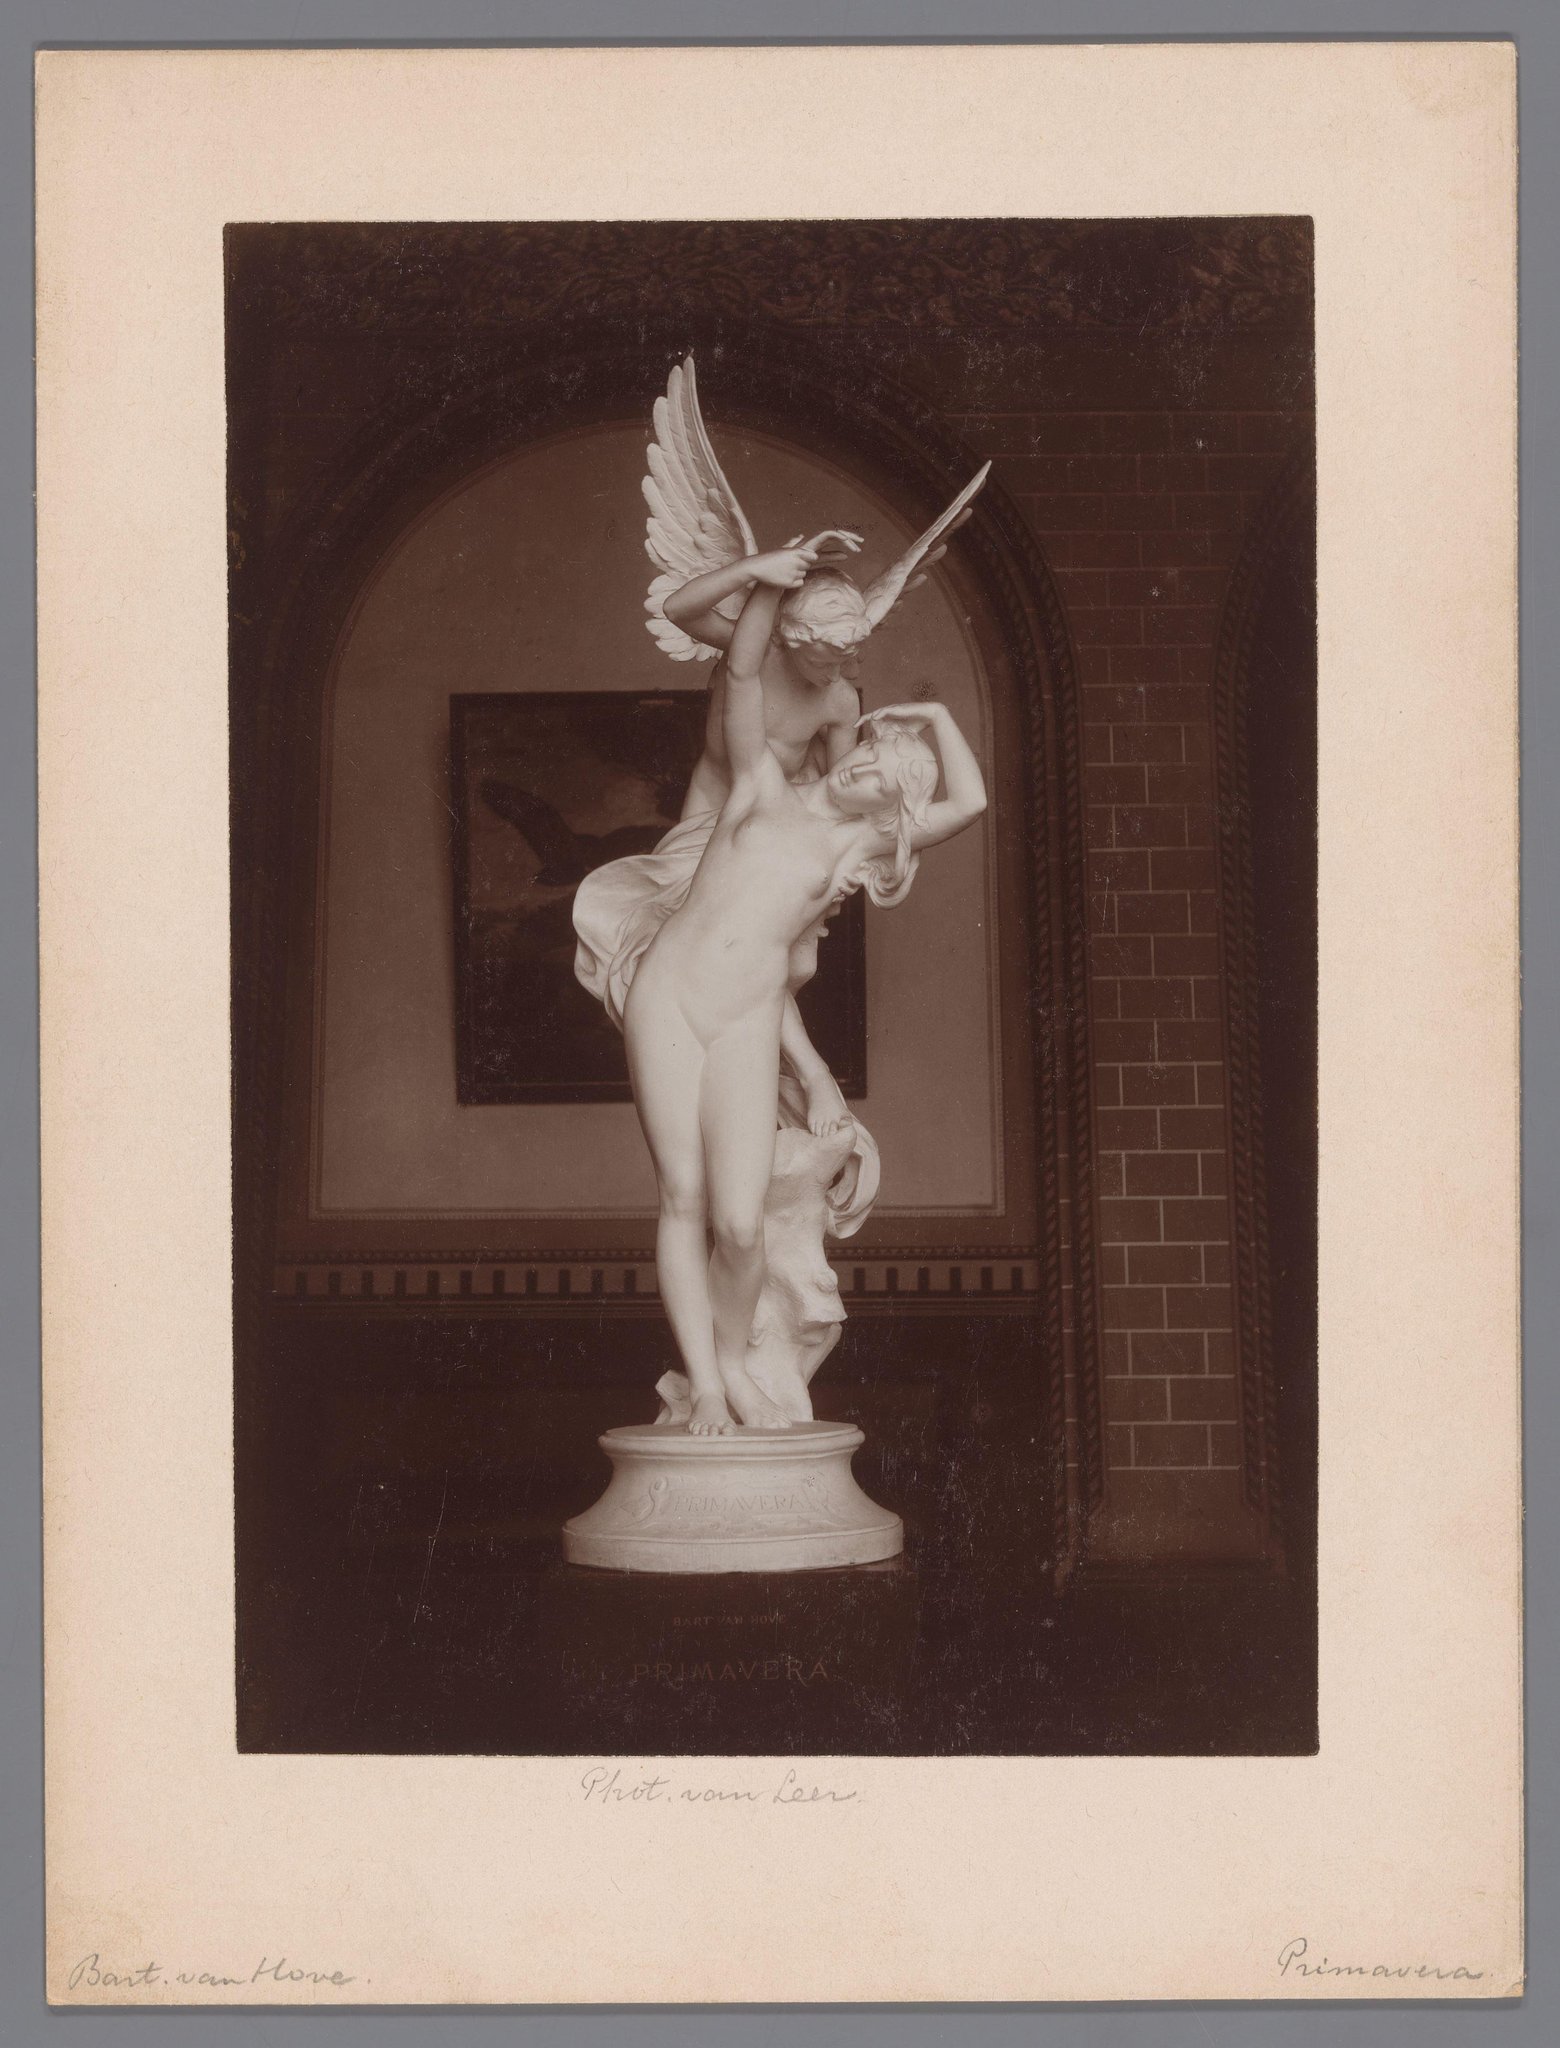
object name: photograph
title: Primavera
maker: Anonymous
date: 1880-1940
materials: paper, cardboard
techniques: collodion silver print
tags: sculpture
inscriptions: inscription: ‘Phot van Leer/ Bart van Hove Primavera’, inscription: ‘Bart van Hove/ Primavera’